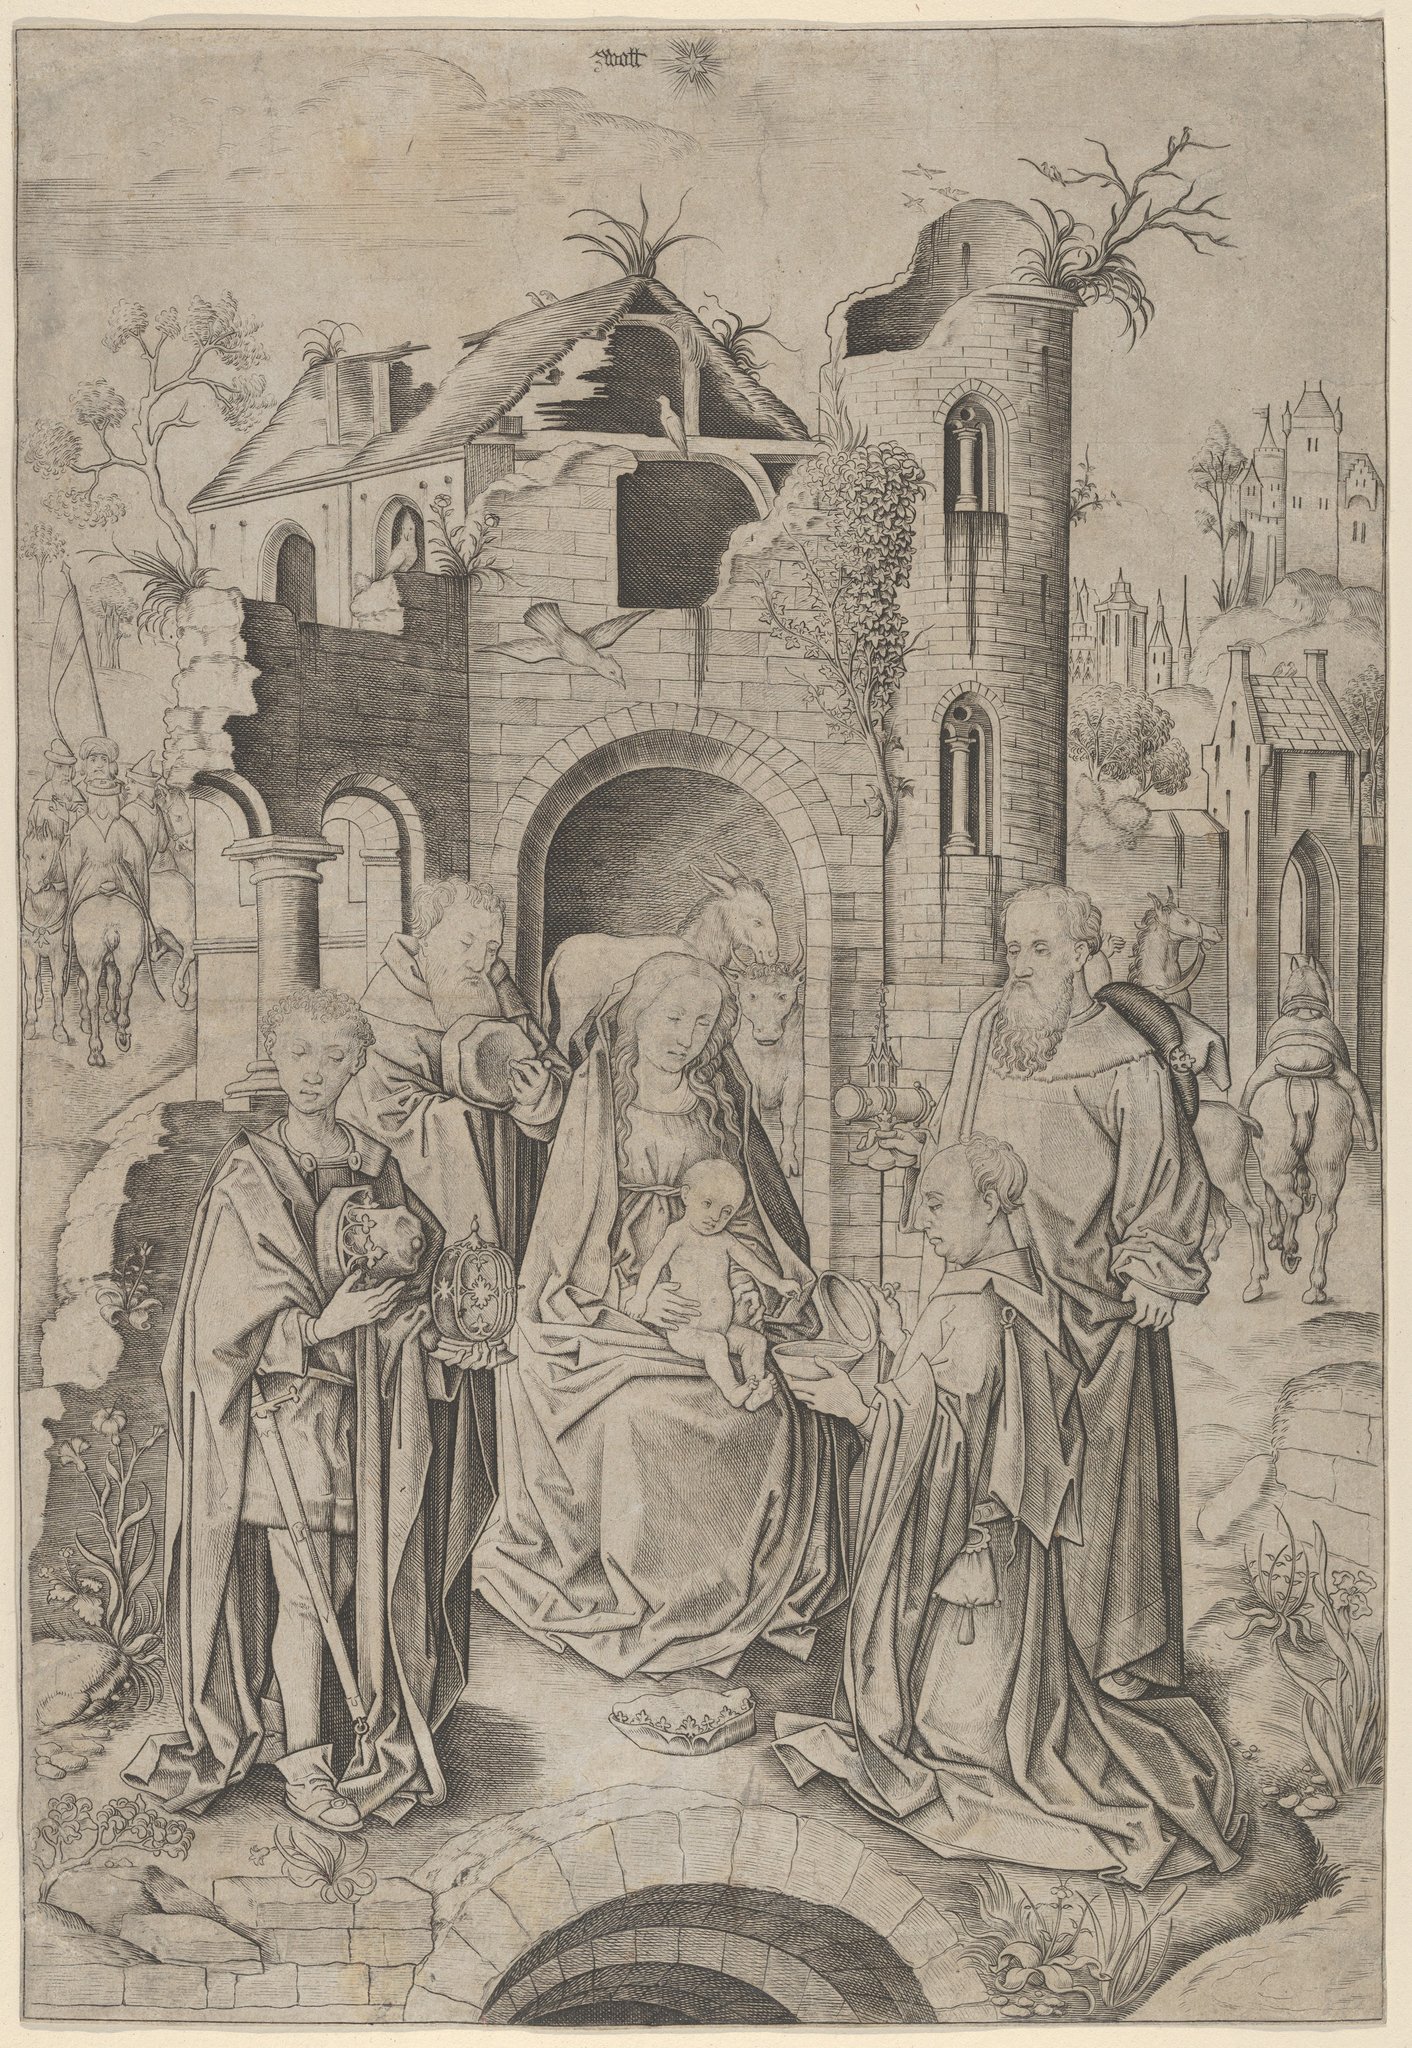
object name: print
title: Adoration of the Magi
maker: master iam of zwolle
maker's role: artist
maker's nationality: netherlandish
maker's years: 1465-1495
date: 1467-1500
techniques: engraving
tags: ruins,adoration of the magi